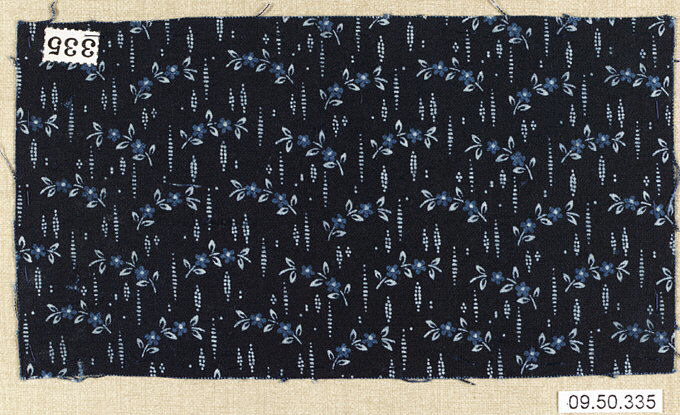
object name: piece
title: Piece (one of 116)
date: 1801-1900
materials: cotton